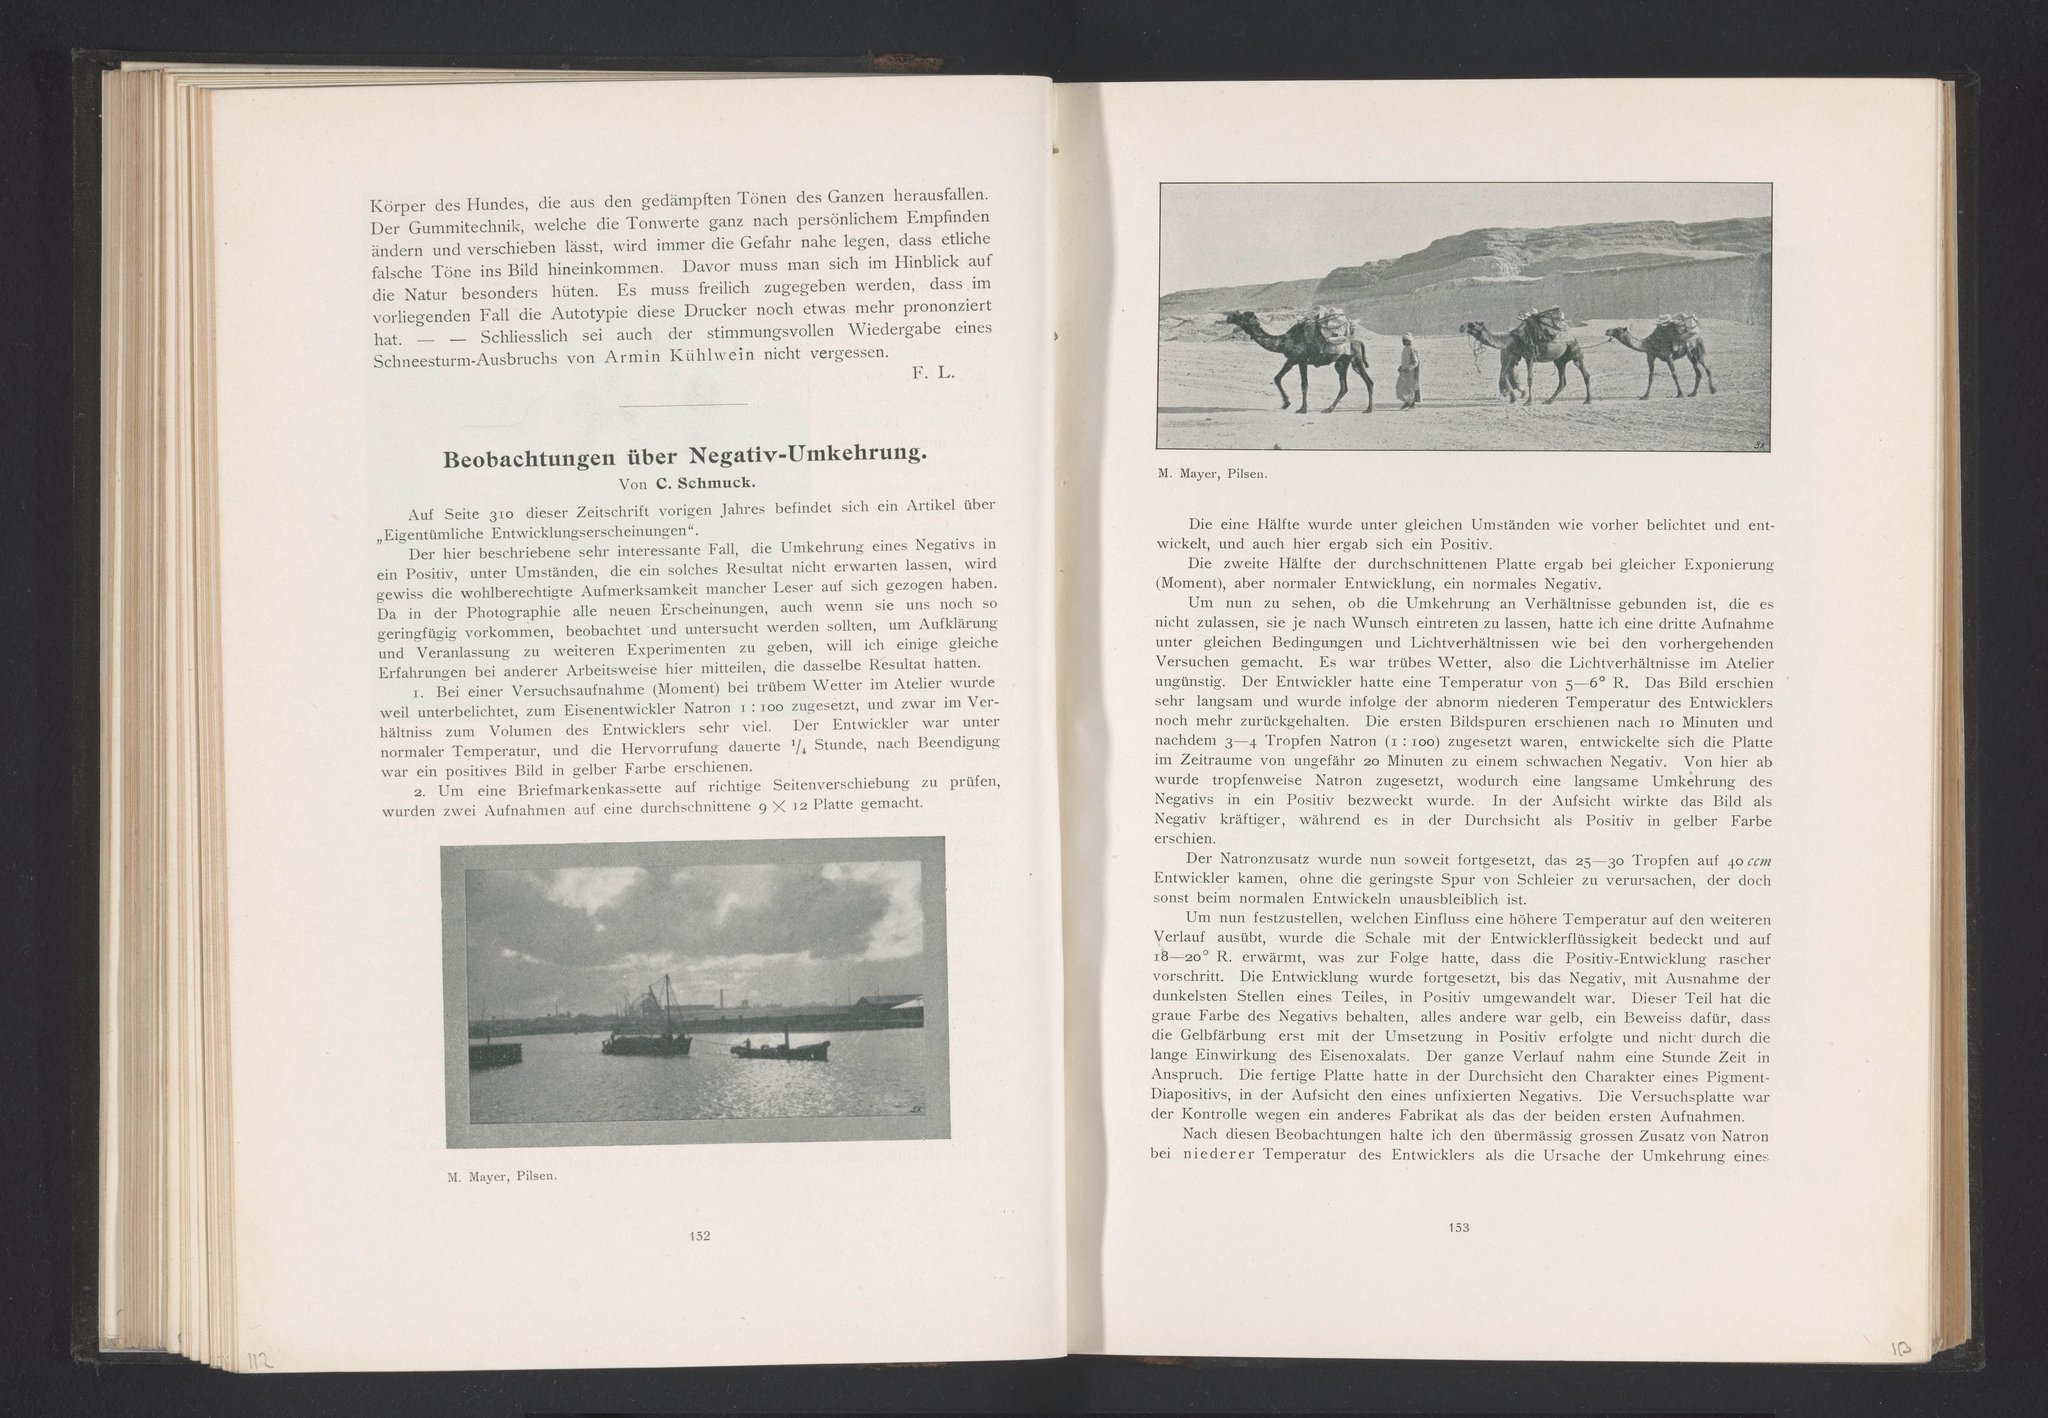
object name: photomechanical print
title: Havengezicht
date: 1898-1903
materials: paper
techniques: autotype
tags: harbour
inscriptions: monogram: ‘BX’